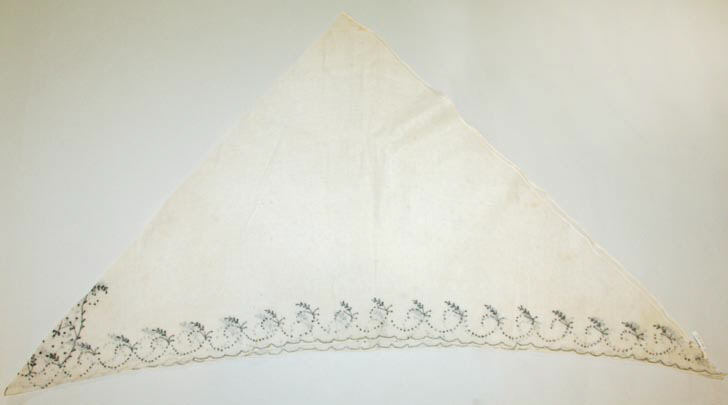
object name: kerchief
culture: american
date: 1801-1833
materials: cotton, metal thread